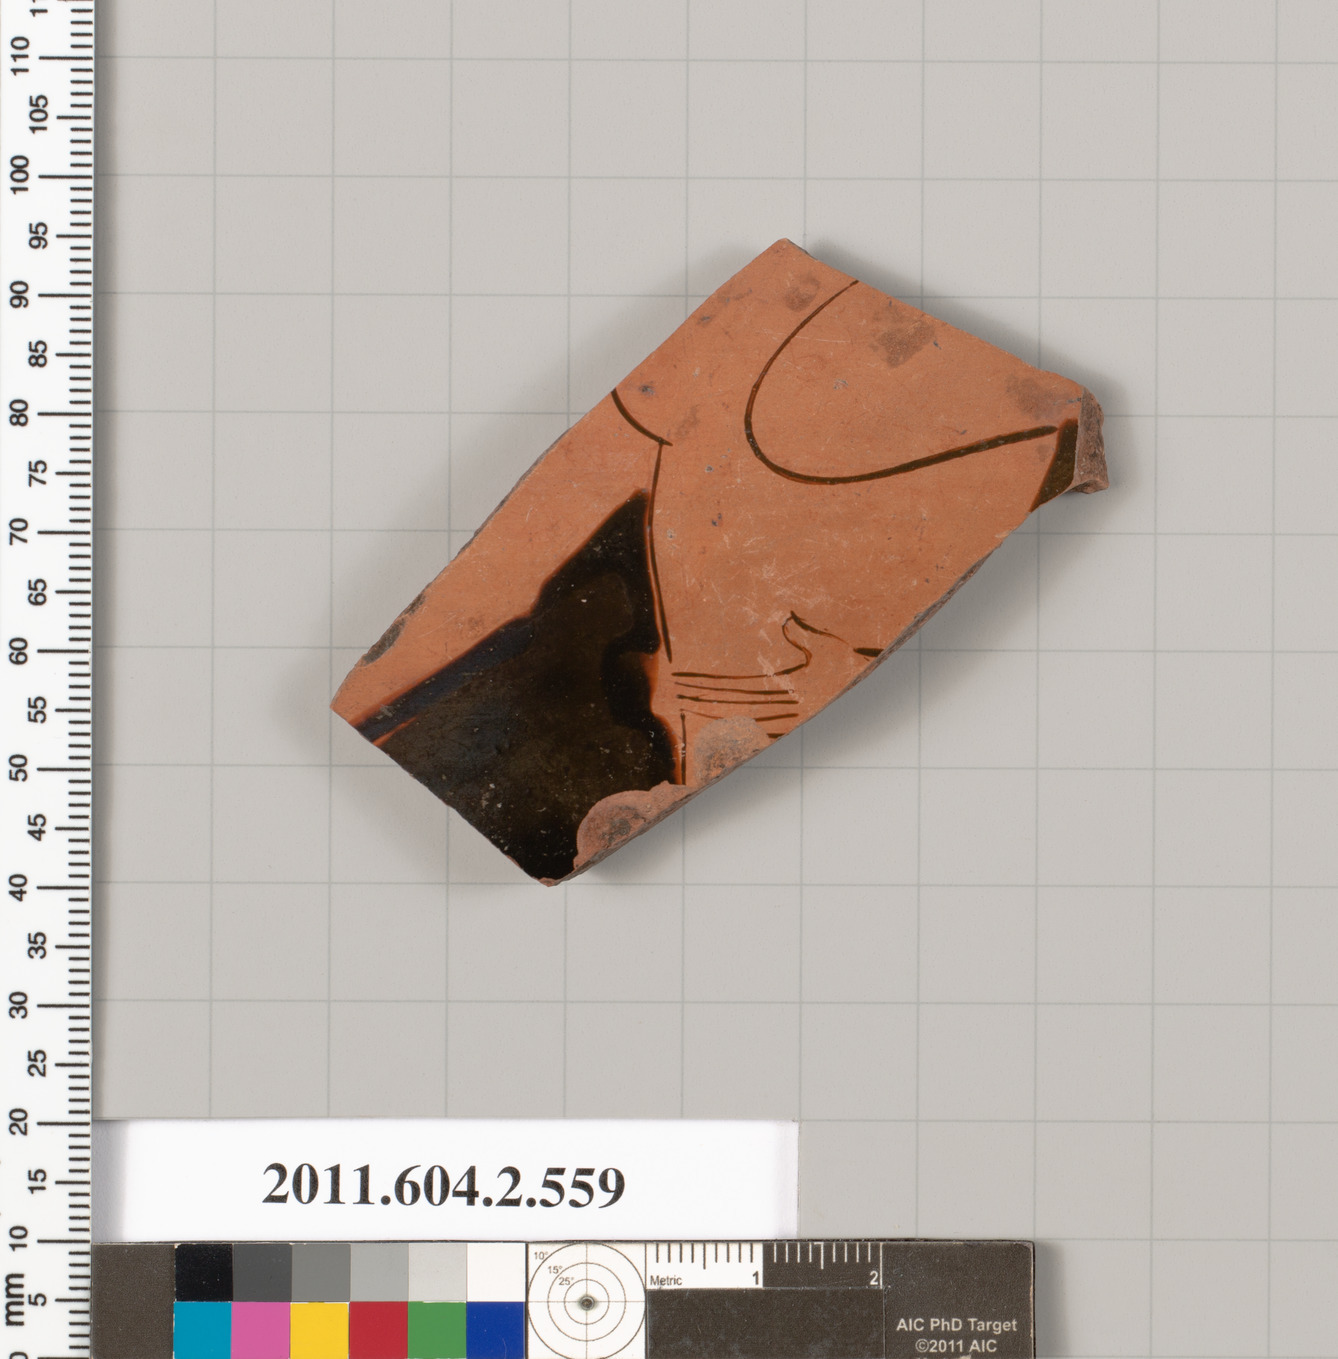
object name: column krater fragment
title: Terracotta fragment of a column-krater (bowl for mixing wine and water)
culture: greek, attic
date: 467-435 BCE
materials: terracotta